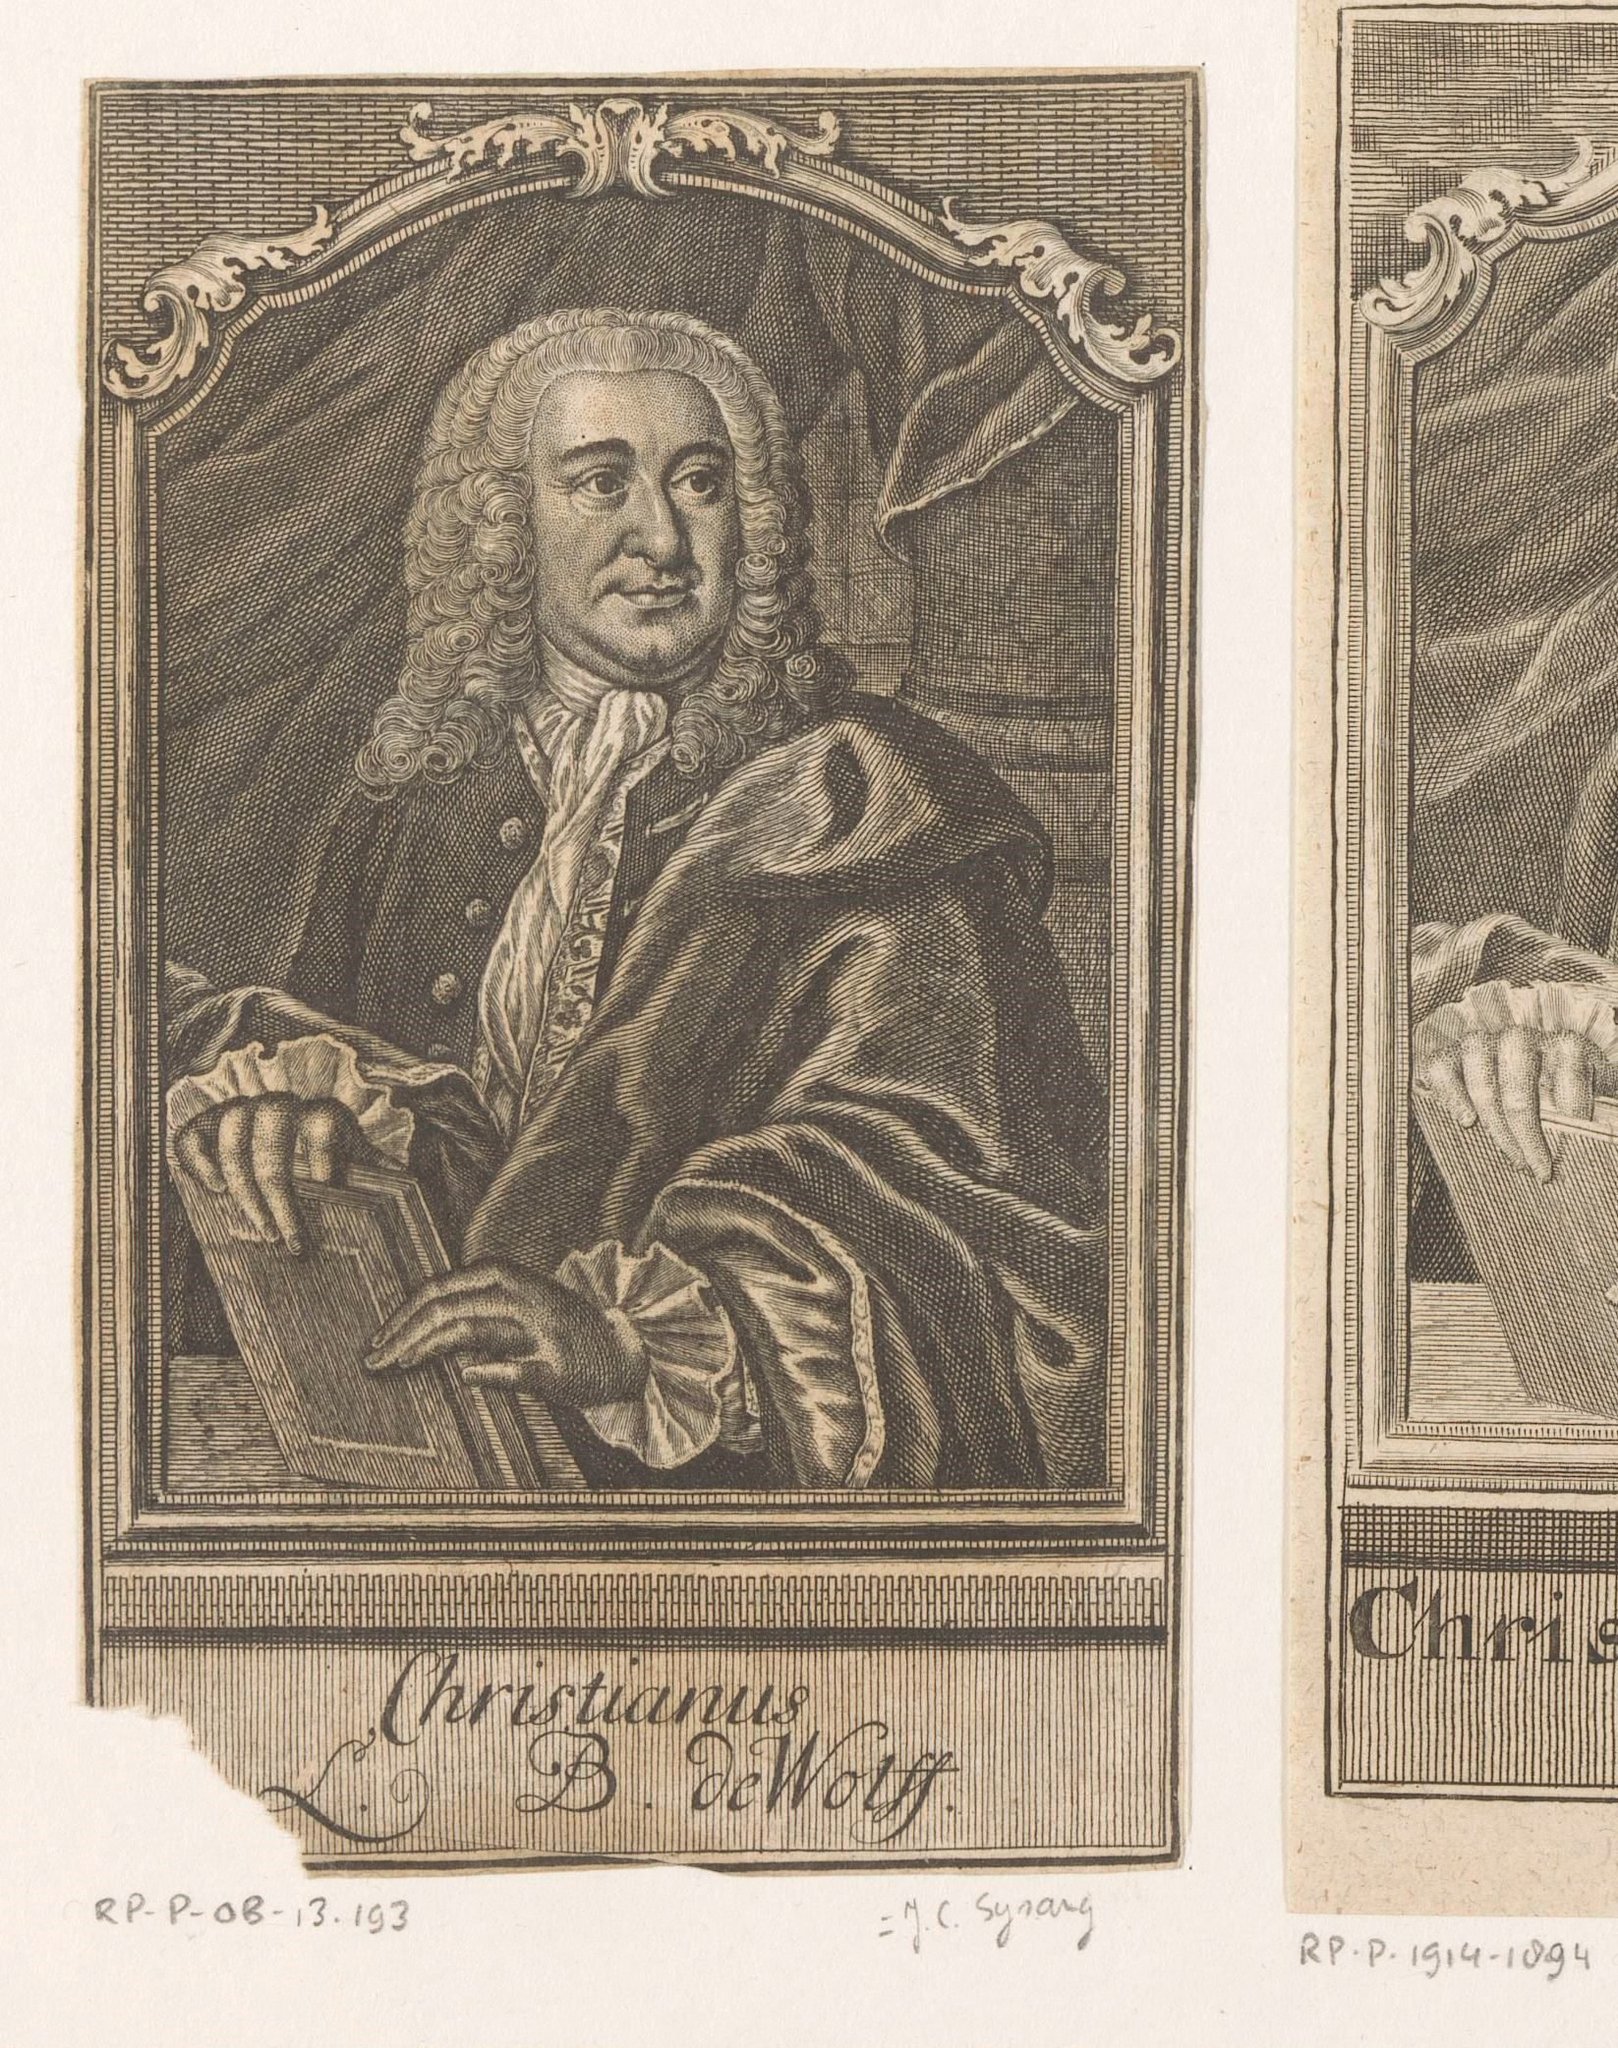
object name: print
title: Portret van Christian Wolff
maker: johann christoph sysang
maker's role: print maker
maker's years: 1703-1757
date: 1746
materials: paper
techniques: engraving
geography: leipzig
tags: historical persons, book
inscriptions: collector's mark: Lugt 2228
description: Prent ook gebruikt in: Wolff, Christian. Auszug aus den Anfangs-Gründen aller Mathematischen Wissenschafften (...). Frankfurt am Main en Leipzig: Johann Gottfried Renger, 1746.